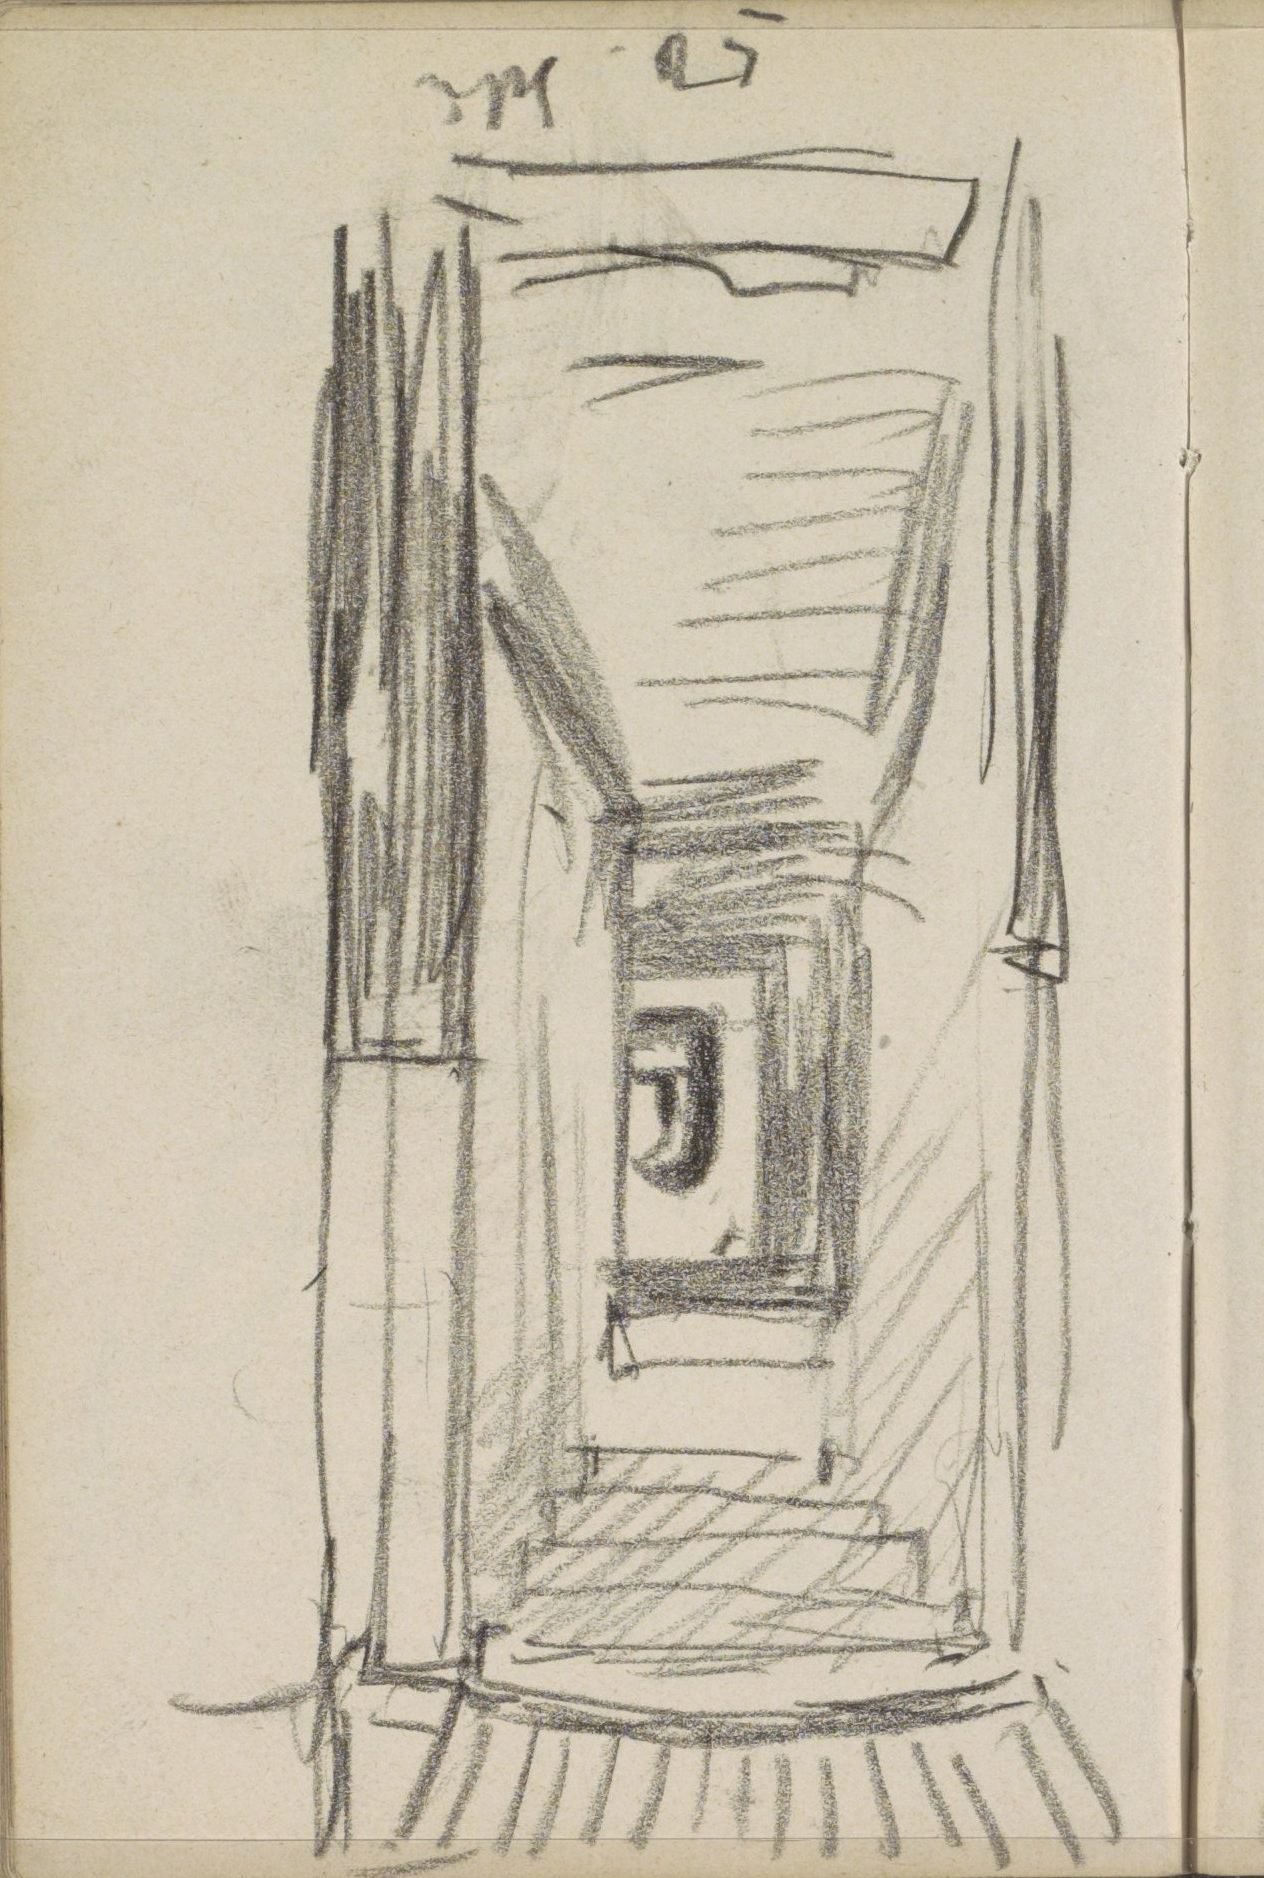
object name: sketchbook leaf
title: Gezicht op een steeg in Amsterdam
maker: george hendrik breitner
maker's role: draughtsman, painter, print maker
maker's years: 1857-1923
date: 1900-1923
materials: chalk, paper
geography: amsterdam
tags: lane, alley (+ city(-scape) with figures, staffage), amsterdam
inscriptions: annotation: ‘50 Schi[?]’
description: Pagina 69 uit een schetsboek met 39 bladen.